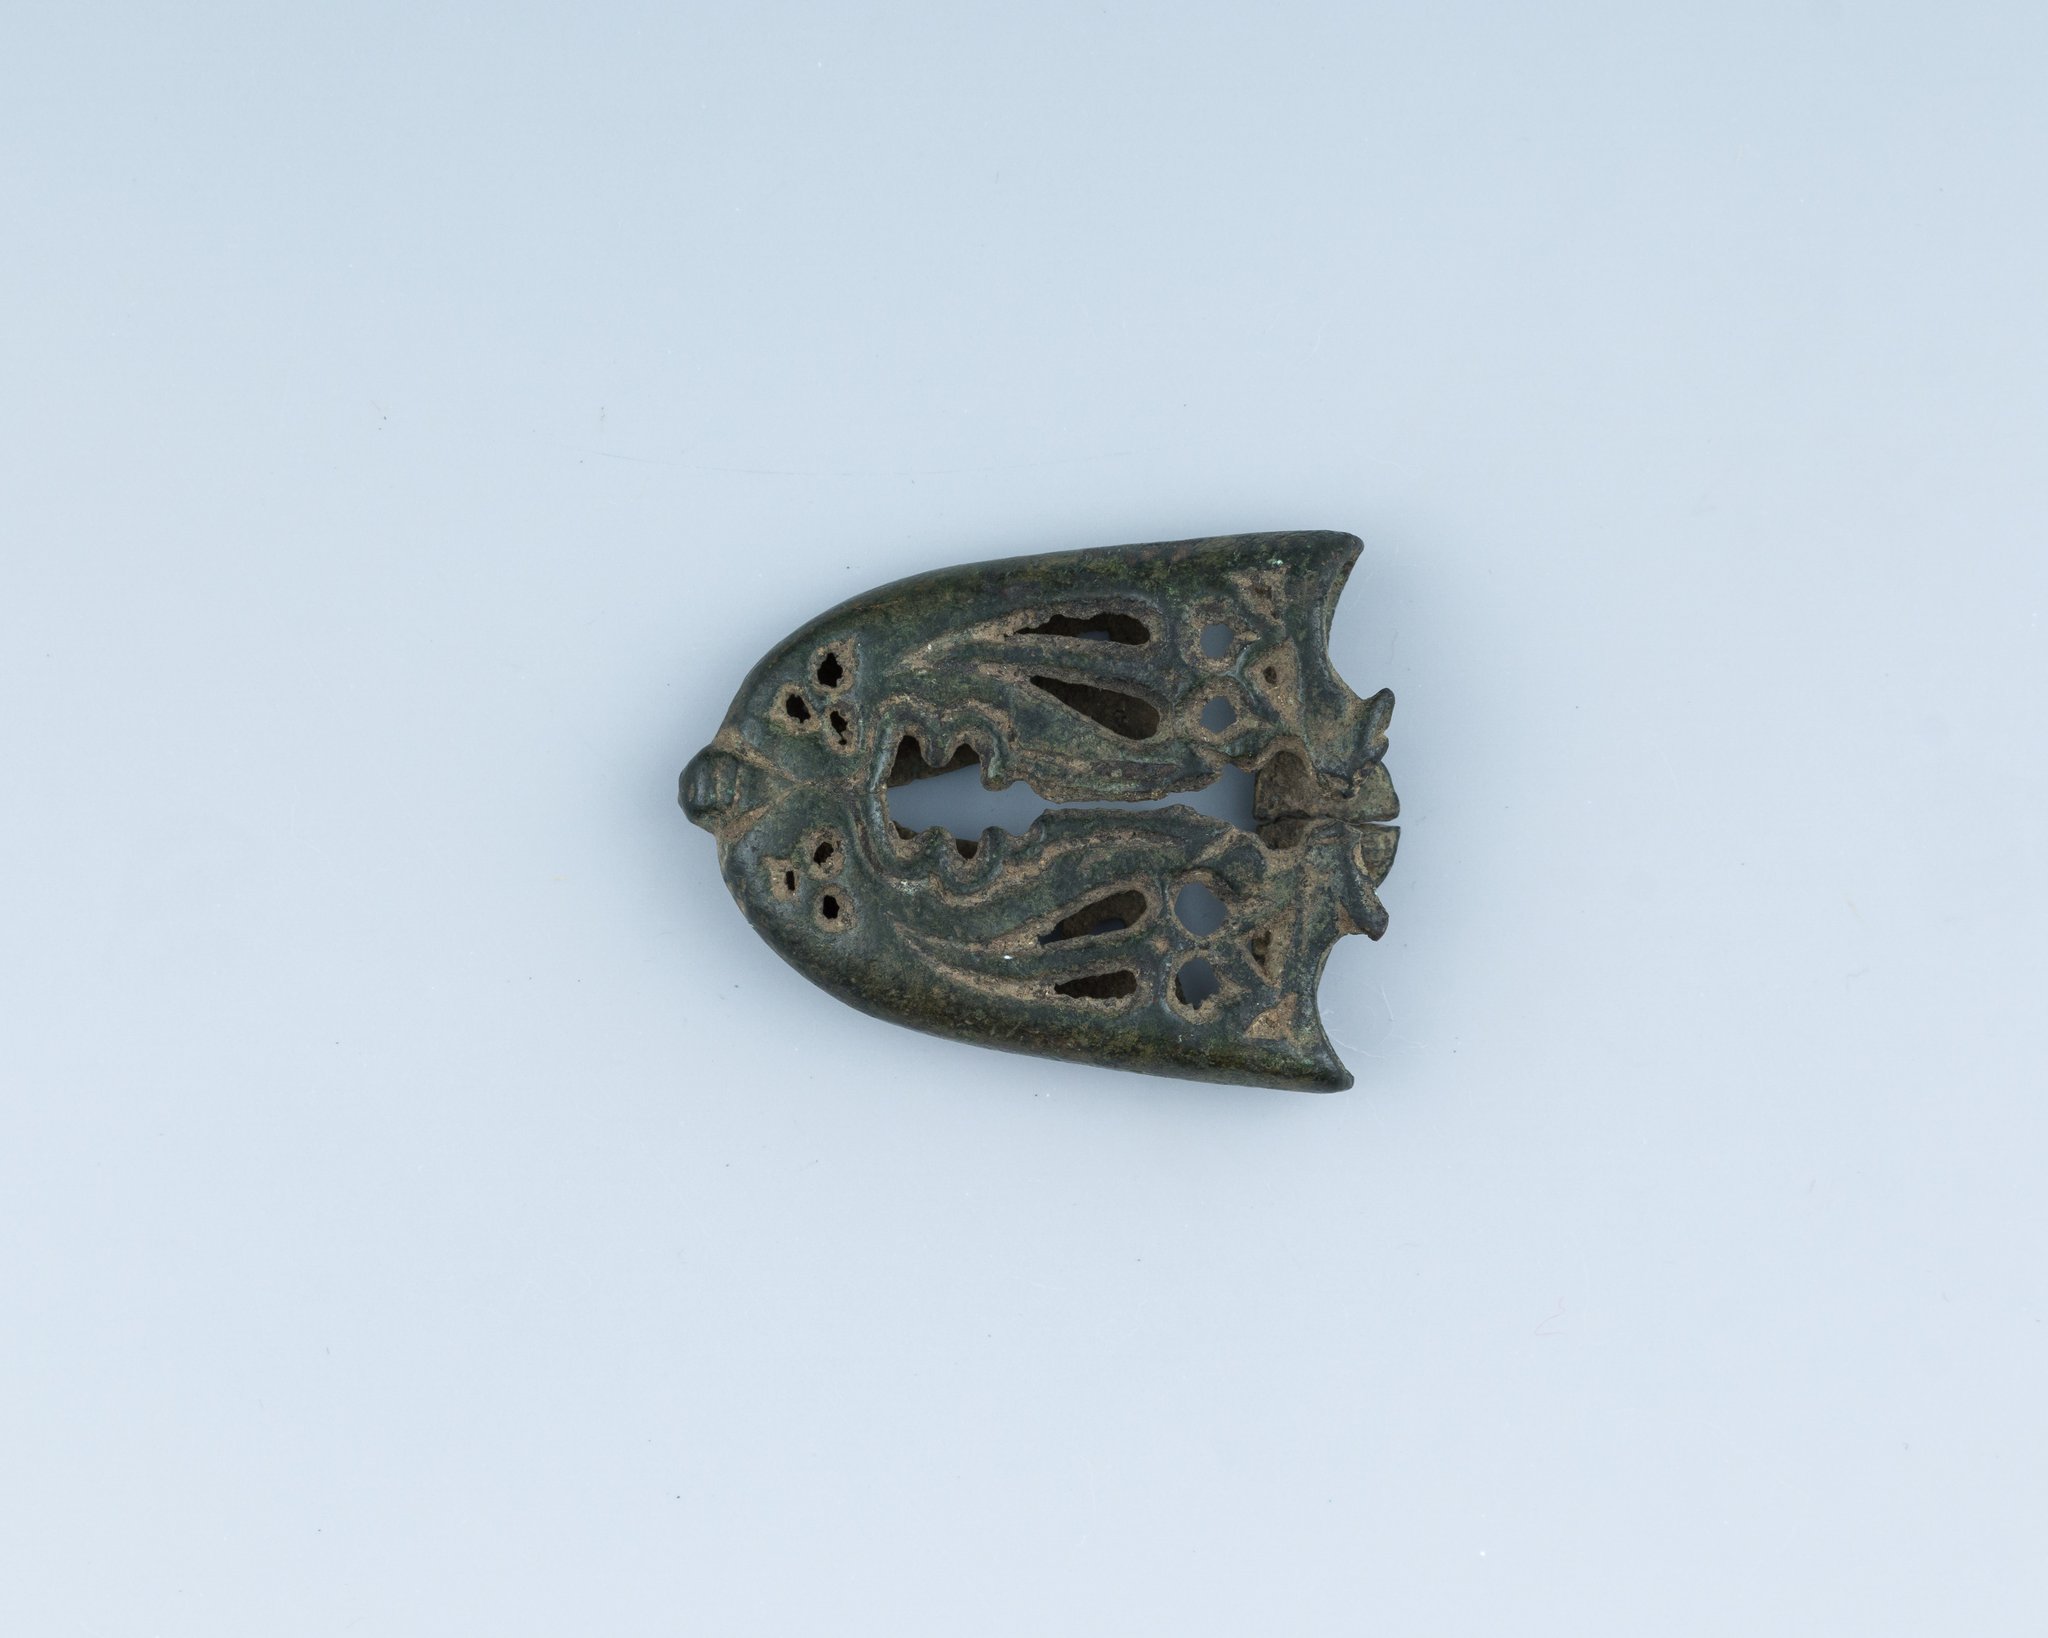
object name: mordant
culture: european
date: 1401-1700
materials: bronze